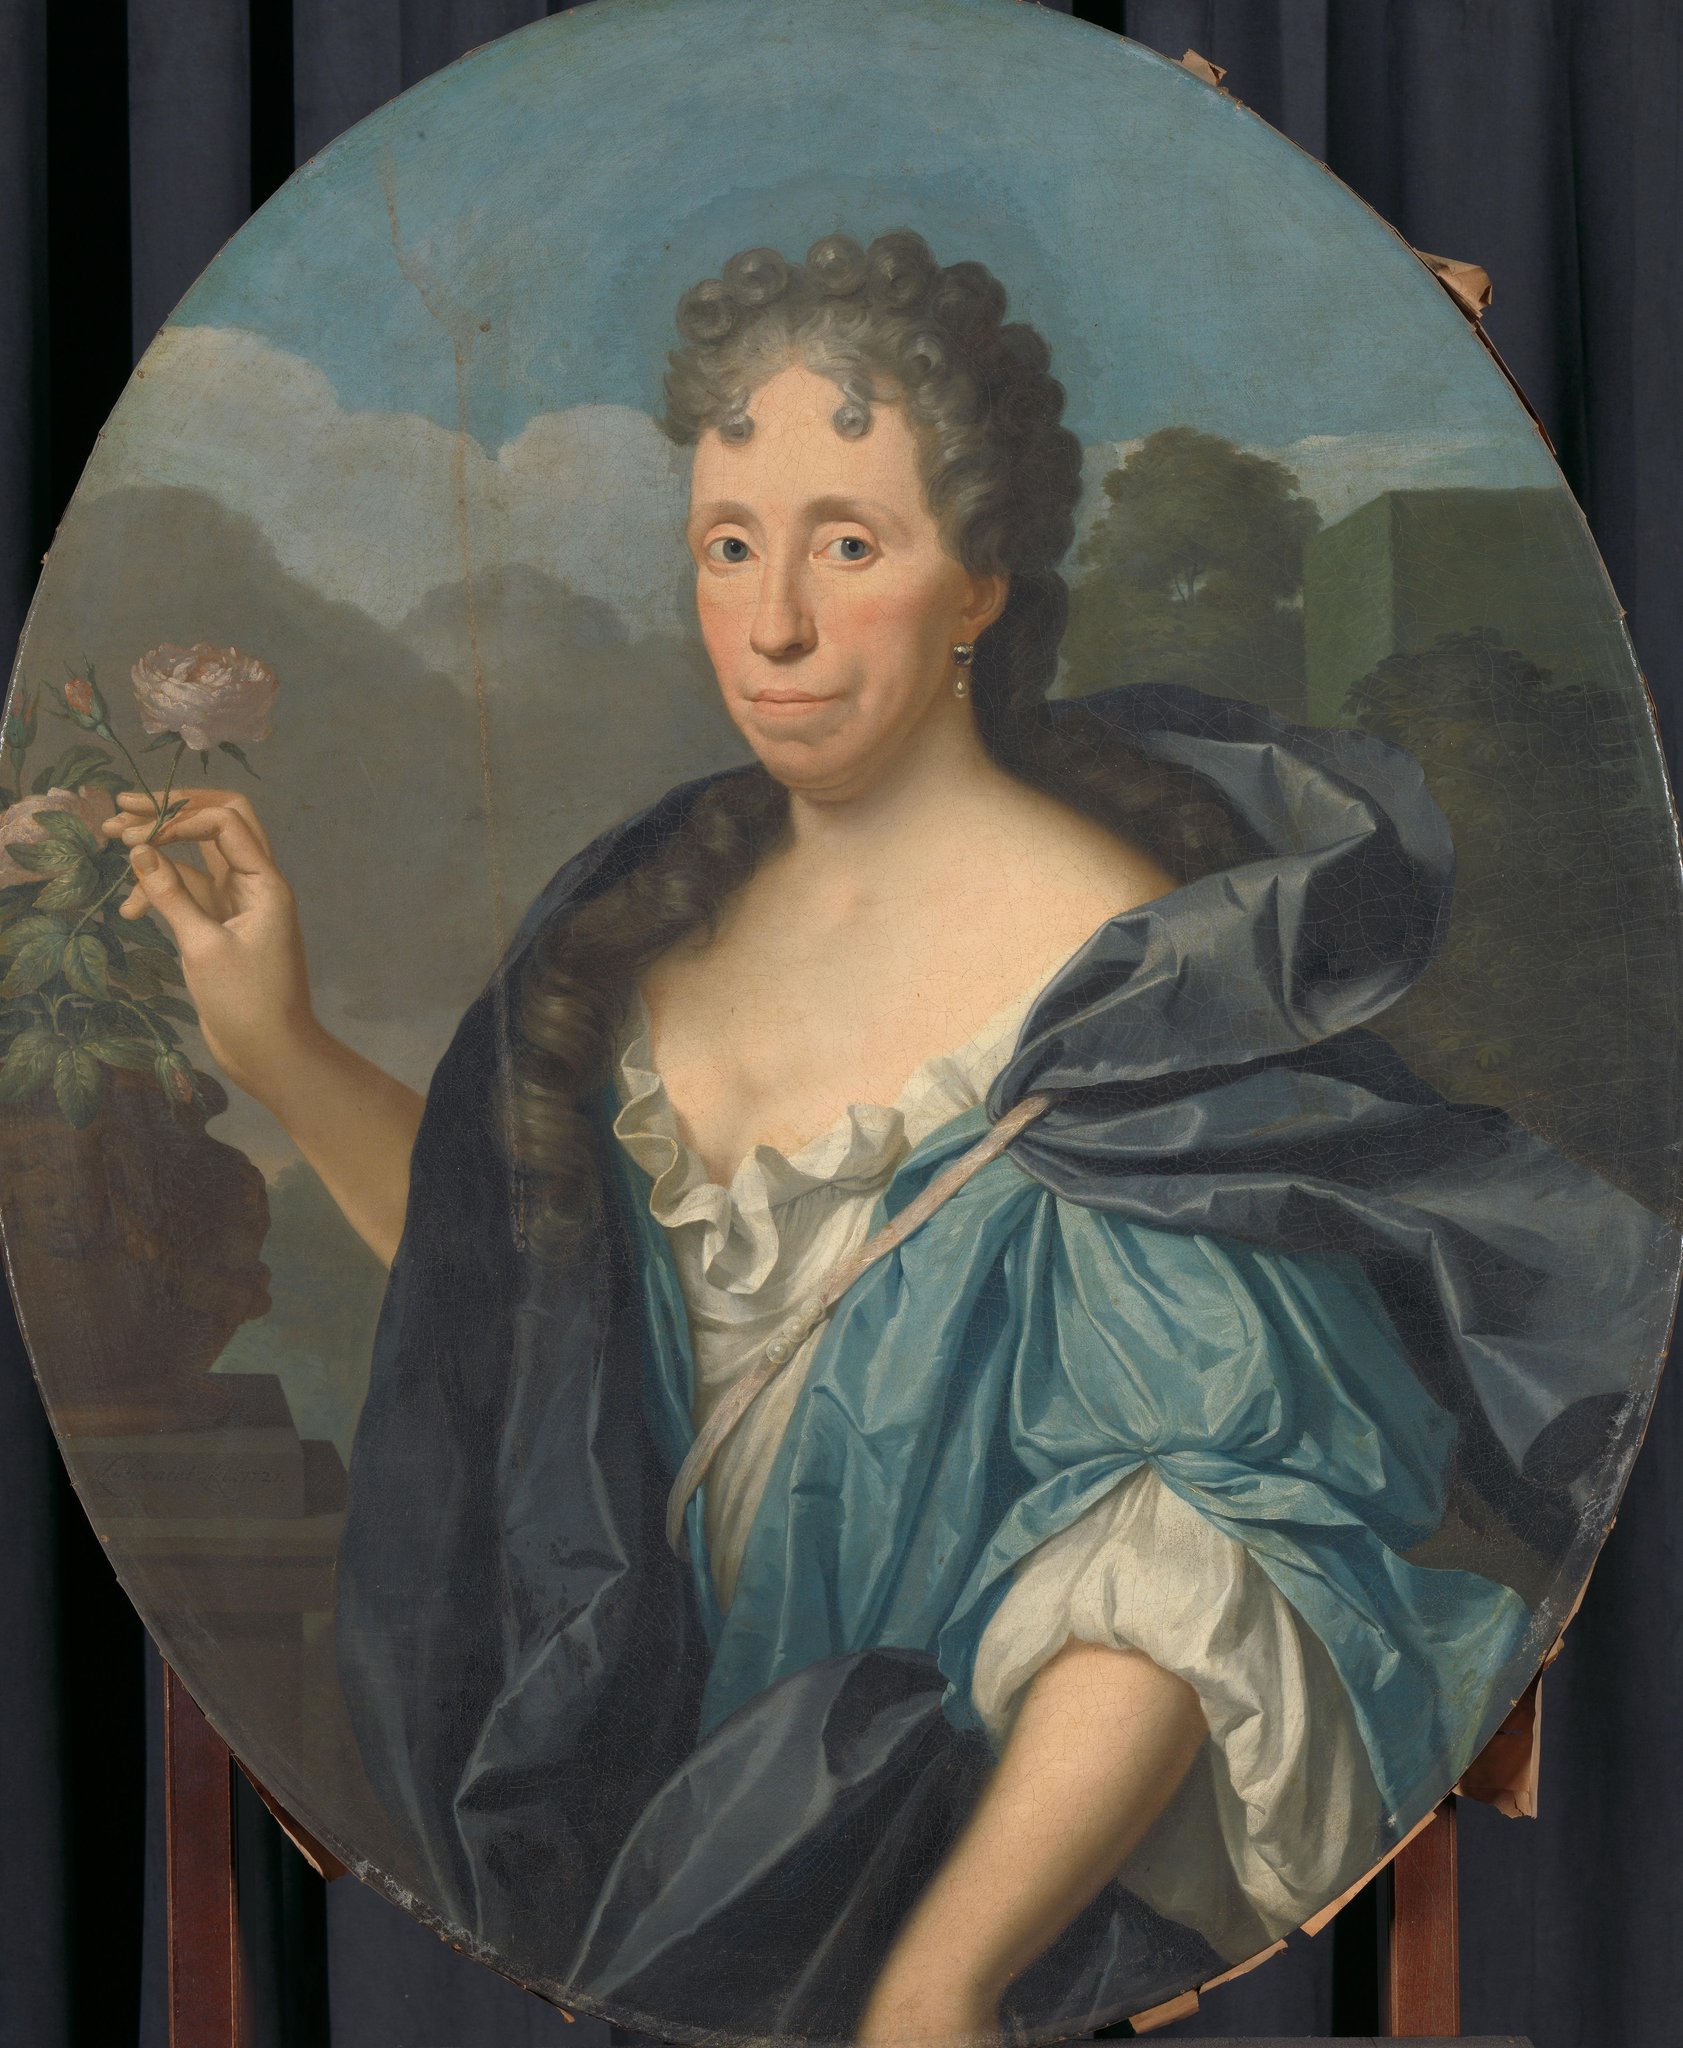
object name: painting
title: Portrait of Sabina Agneta d'Acquet, Wife of Arent van Buren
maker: christoffel lubienitzki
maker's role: draughtsman, painter, print maker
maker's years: 1659-1729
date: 1721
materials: canvas, oil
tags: delft, historical persons - bb - woman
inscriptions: signature and date: ‘C. Lubienietzki 1721’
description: Portret van Sabina Agneta d'Acquet, echtgenote van Arent van Buren. Ten halven lijve, in ovaal, met de rechterhand neemt zij een roos uit een boeket in een vaas op de balustrade. Pendant van SK-A-1550.